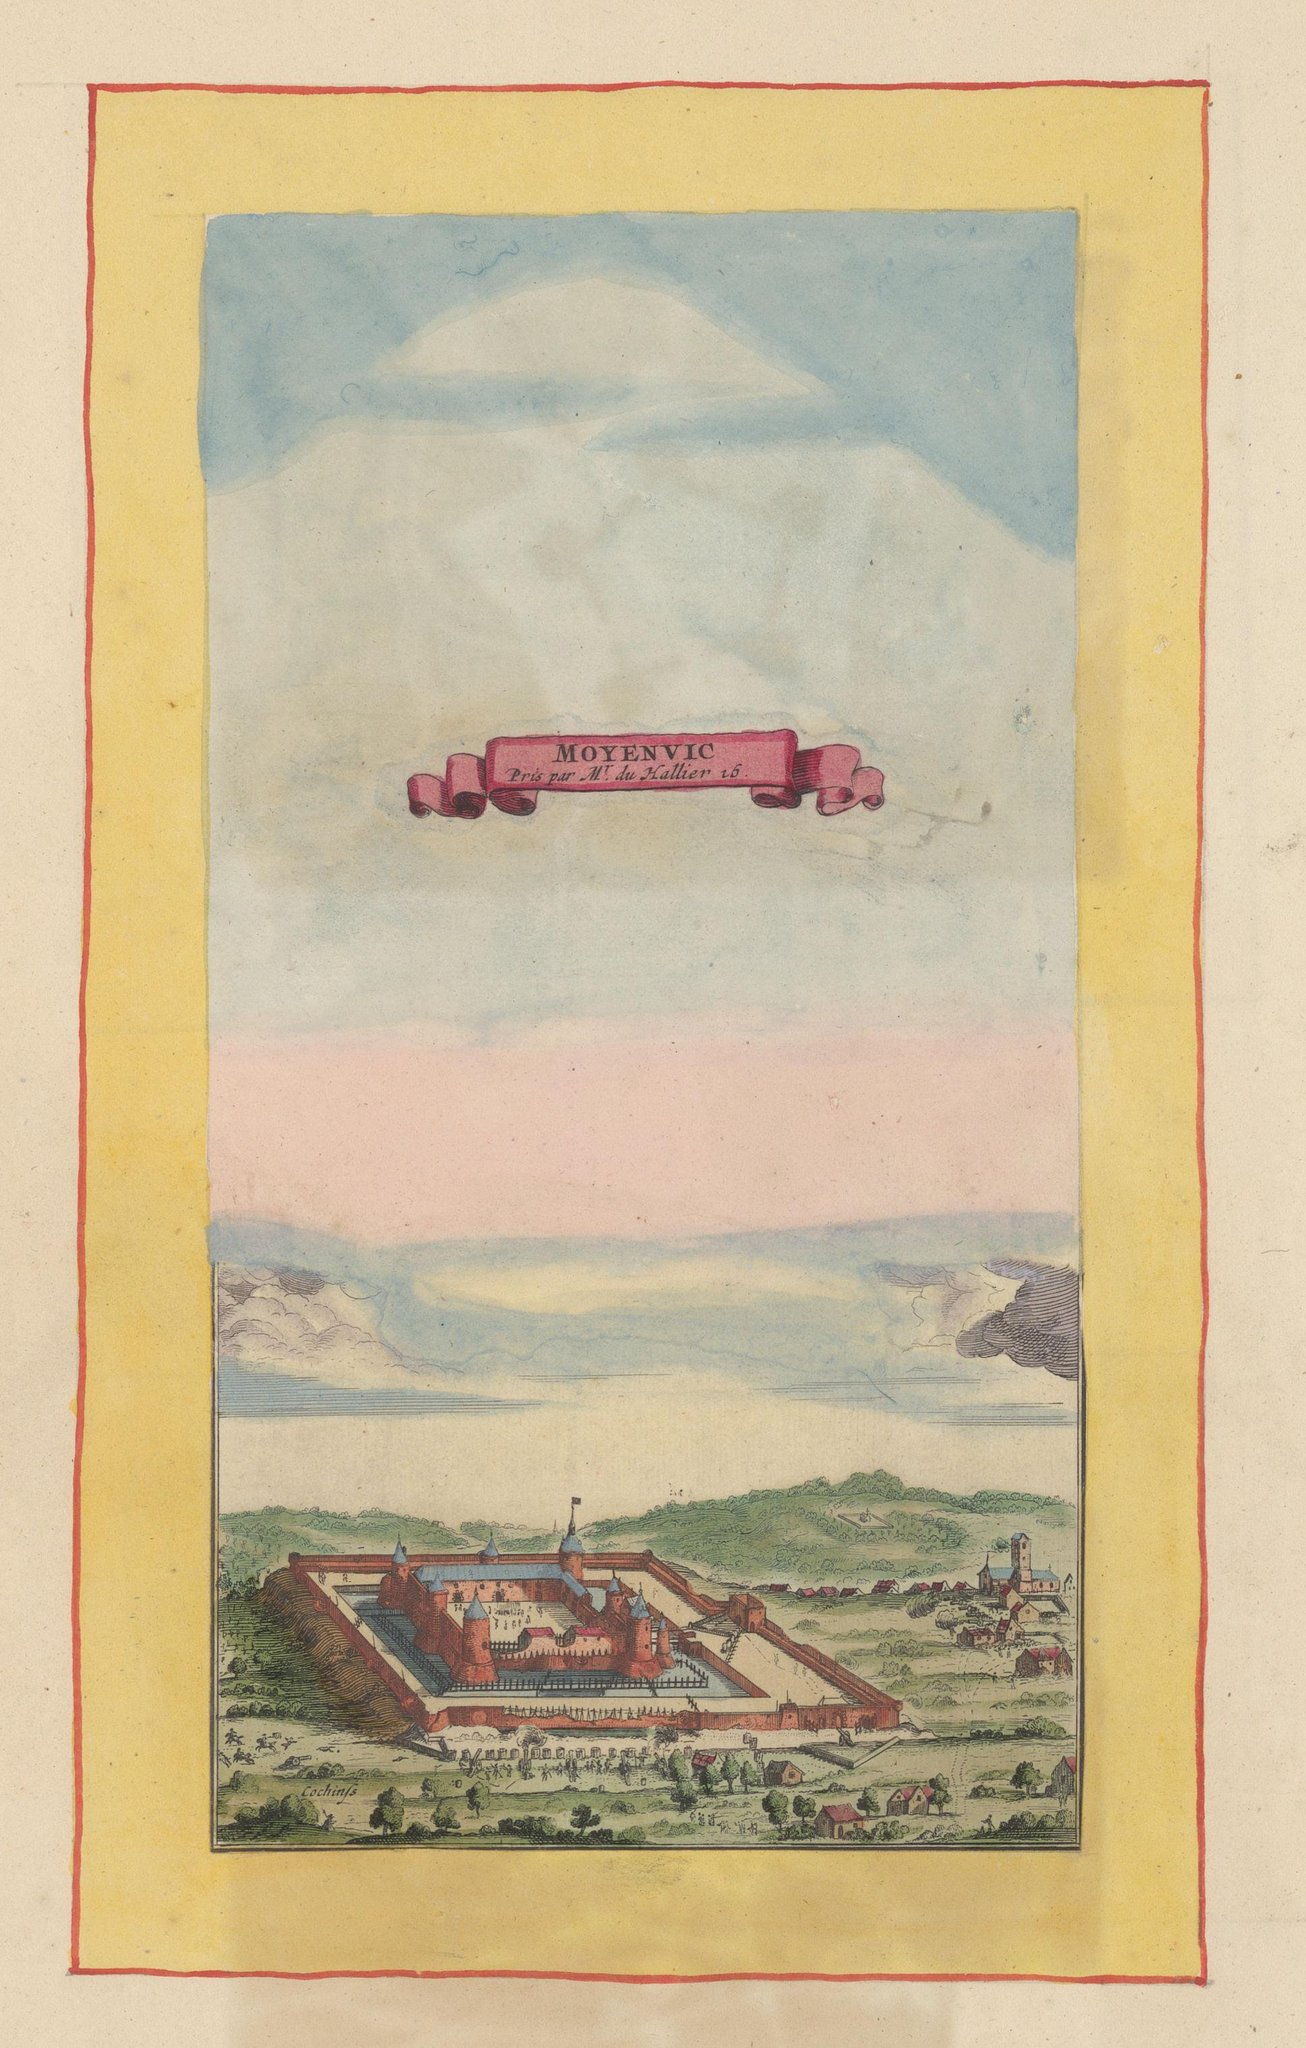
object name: album leaf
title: Moyenvic pris par mt. du Hallier 16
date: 1700-1702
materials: paper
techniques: engraving, hand coloring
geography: amsterdam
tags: city-view in general; 'veduta'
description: Deze plattegrond is in meerdere atlassen gebruikt. Onder andere in: Les forces de l'Europe. 10 dln. Amsterdam: Pieter Mortier, ca. 1700. En in: Les forces de l'Europe. 12 dln. Amsterdam: Pieter Mortier, 1702. Door het ontbreken van de marges van deze prent is onduidelijk om welke staat het gaat. Derhalve is niet te bepalen uit welke van deze publicaties dit exemplaar komt. Later is deze zelfde prent door Pieter van der Aa gebruikt in twee publicaties. Gezien het eind van de werkzame periode van de inkleurder van de prenten in dit album is het niet mogelijk dat deze prent uit een van die publicaties komt.